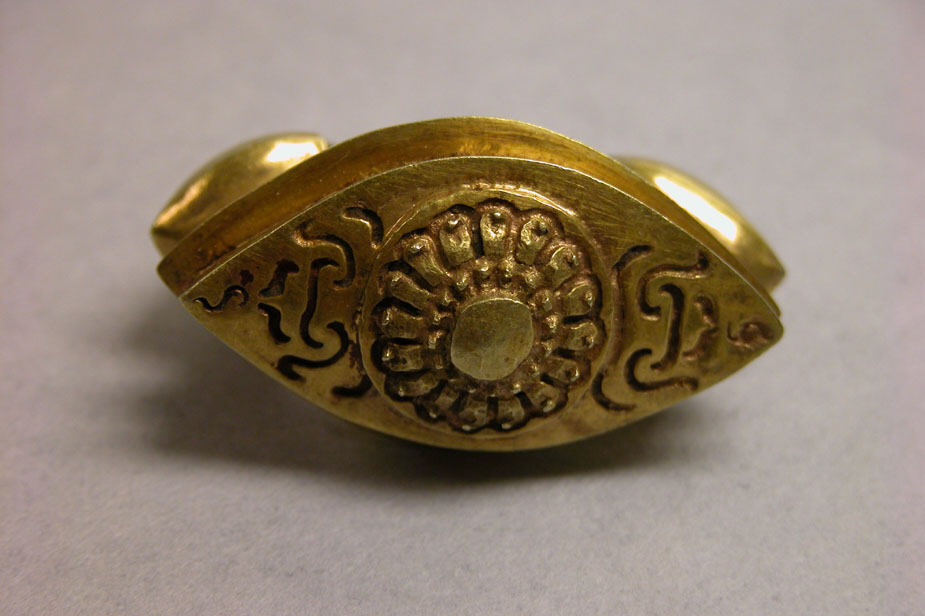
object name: ring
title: Ring with Almond-Shaped Bezel with "Sri" Inscription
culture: indonesian, javanese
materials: gold